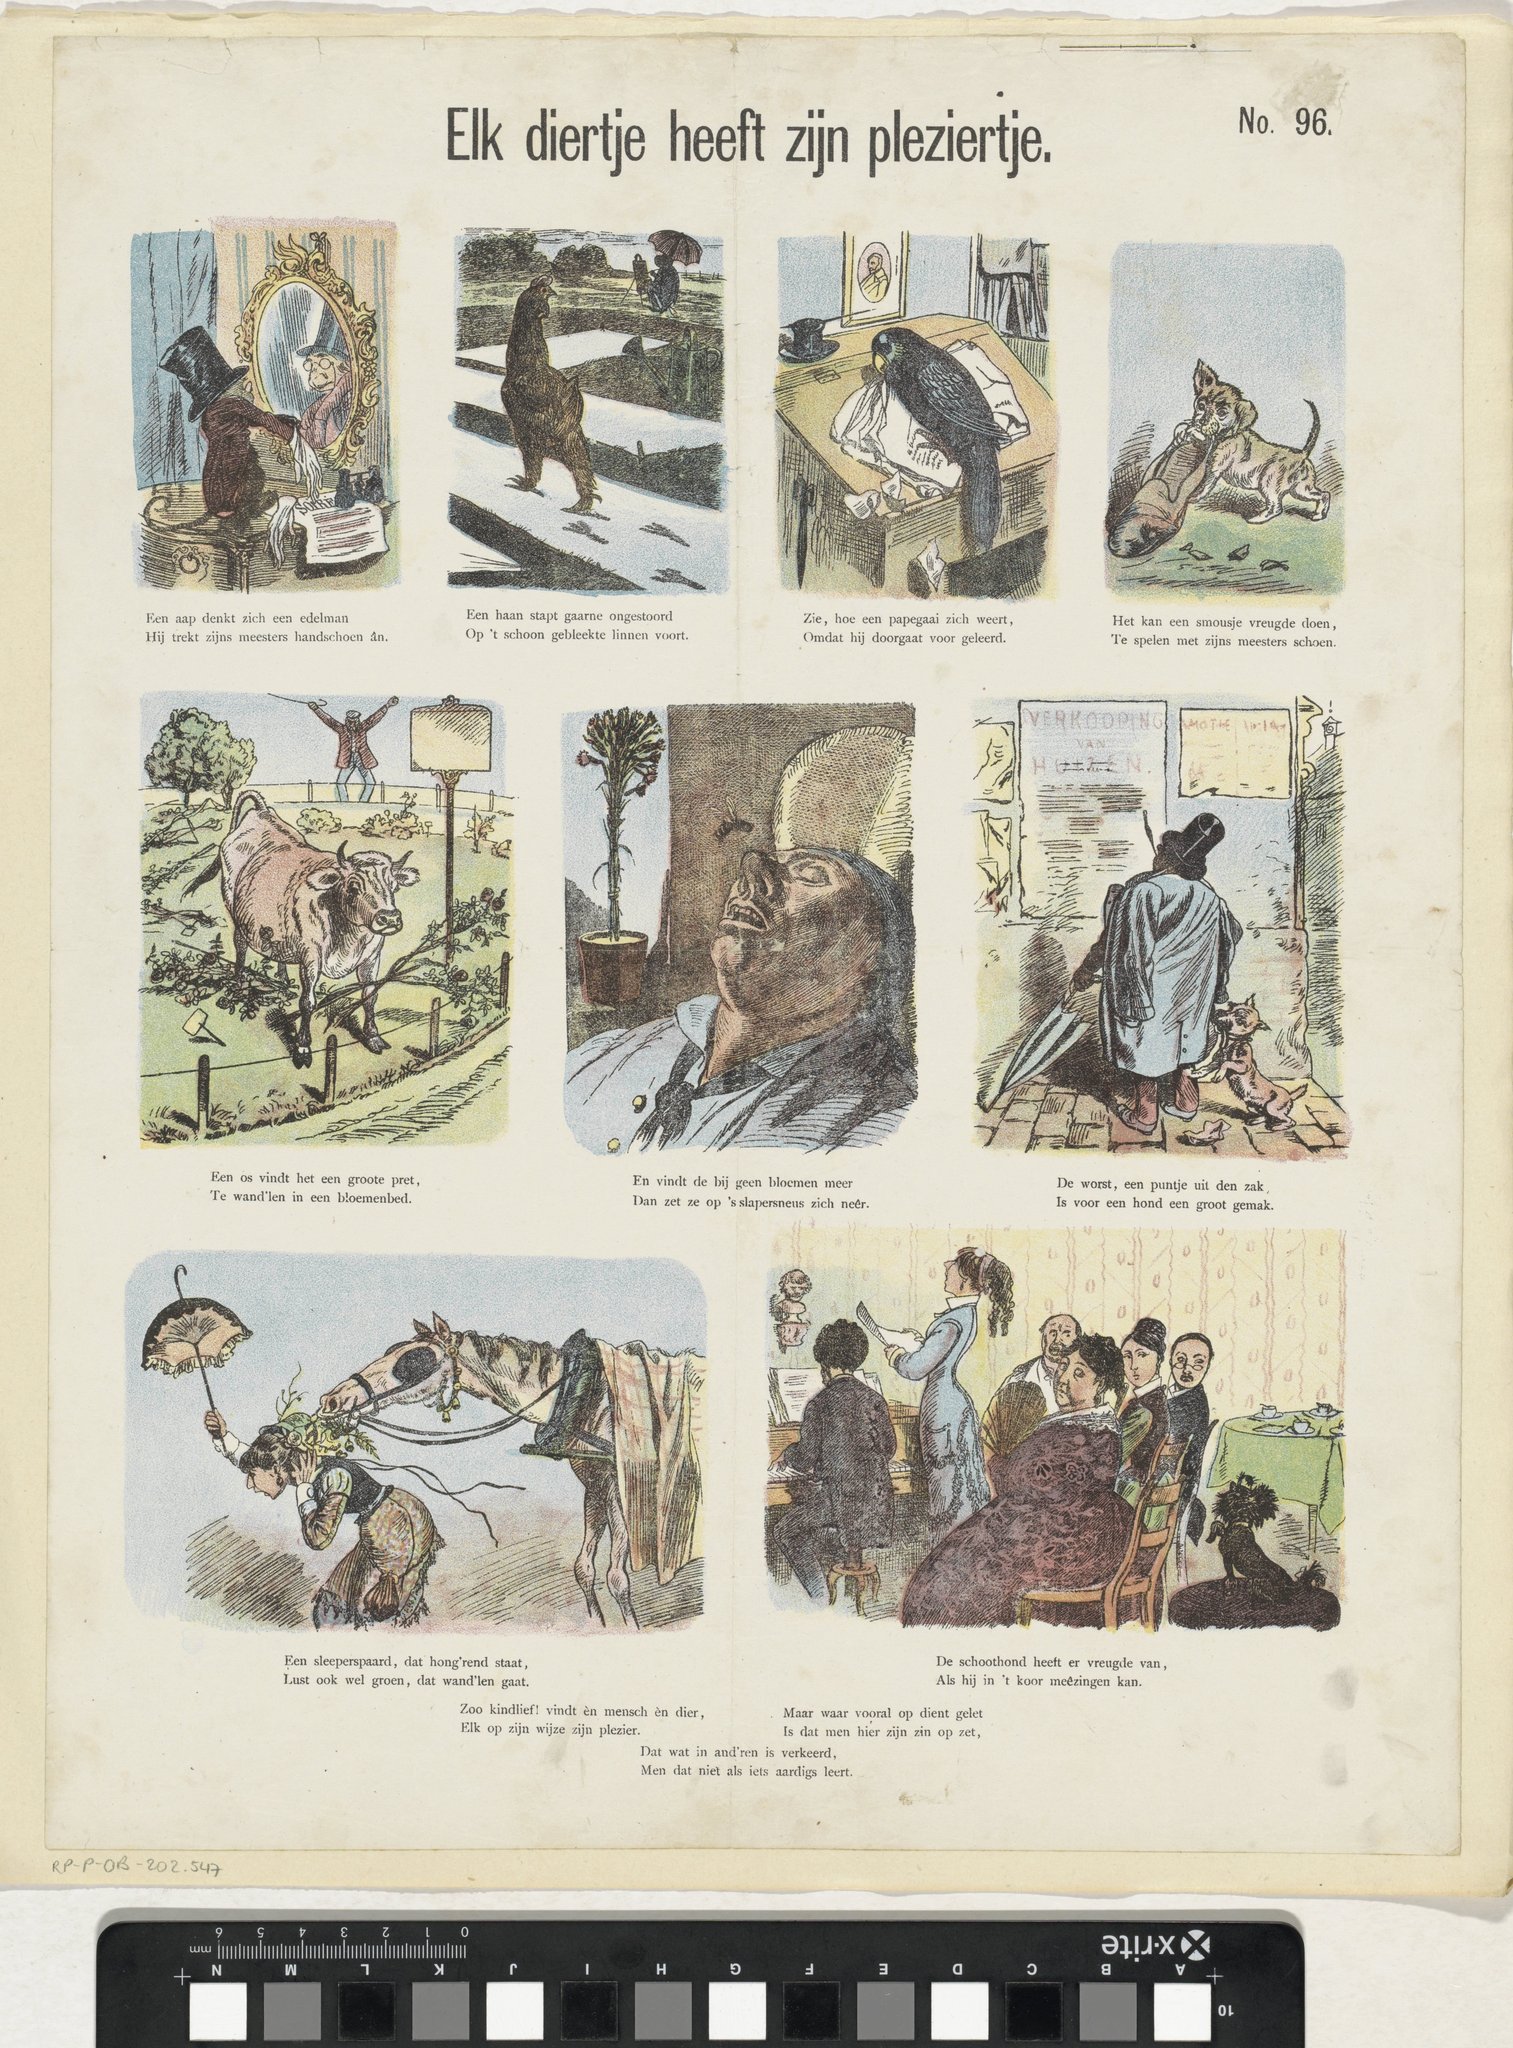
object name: popular print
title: Elk diertje heeft zijn pleziertje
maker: Anonymous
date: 1881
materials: paper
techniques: lithograph, letterpress printing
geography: amsterdam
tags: animals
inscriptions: collector's mark: Lugt 2760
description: Blad met 9 voorstellingen over dieren die mensen in problemen brengen. Onder elke afbeelding een onderschrift. Genummerd rechtsboven: No. 96.